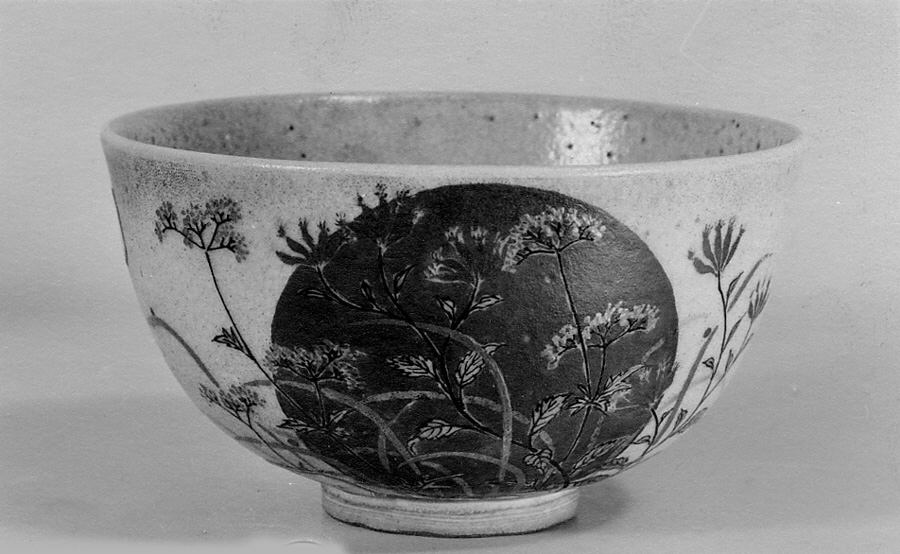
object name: teabowl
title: Tea Bowl with Design of Moon and Autumn Grasses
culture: japanese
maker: eiraku hozen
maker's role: artist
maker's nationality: japanese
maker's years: 1795-1854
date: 1825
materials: clay, enamel, glaze, gold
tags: moon,plants